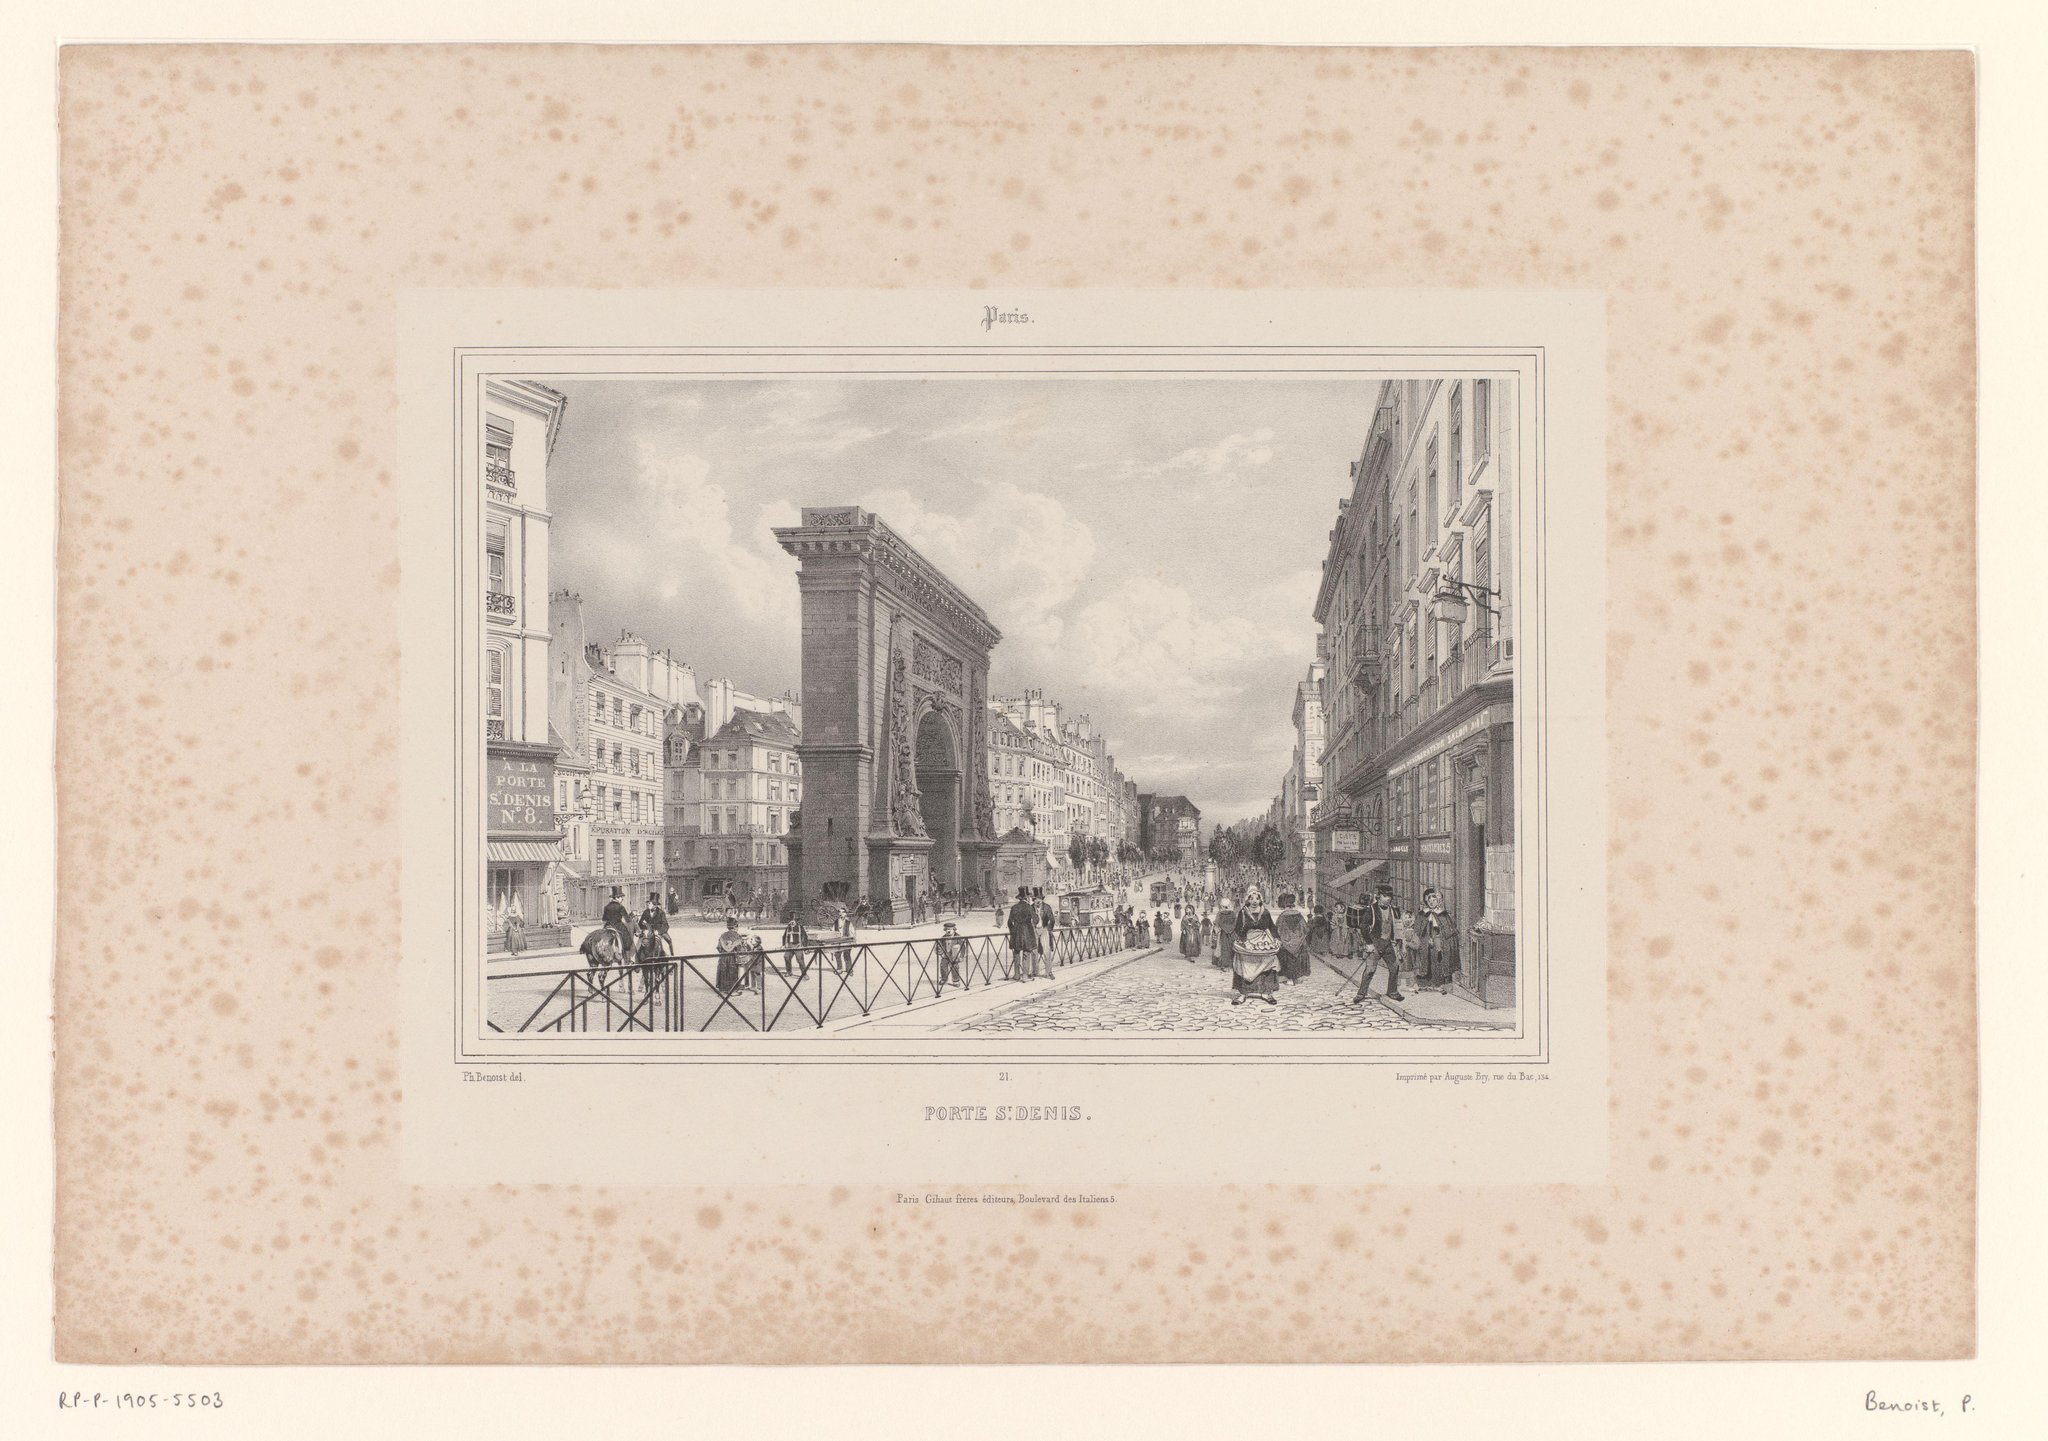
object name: print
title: Zicht op de Porte Saint-Denis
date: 1843-1844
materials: paper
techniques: lithograph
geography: paris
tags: triumphal arch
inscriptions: collector's mark: Lugt 2228a